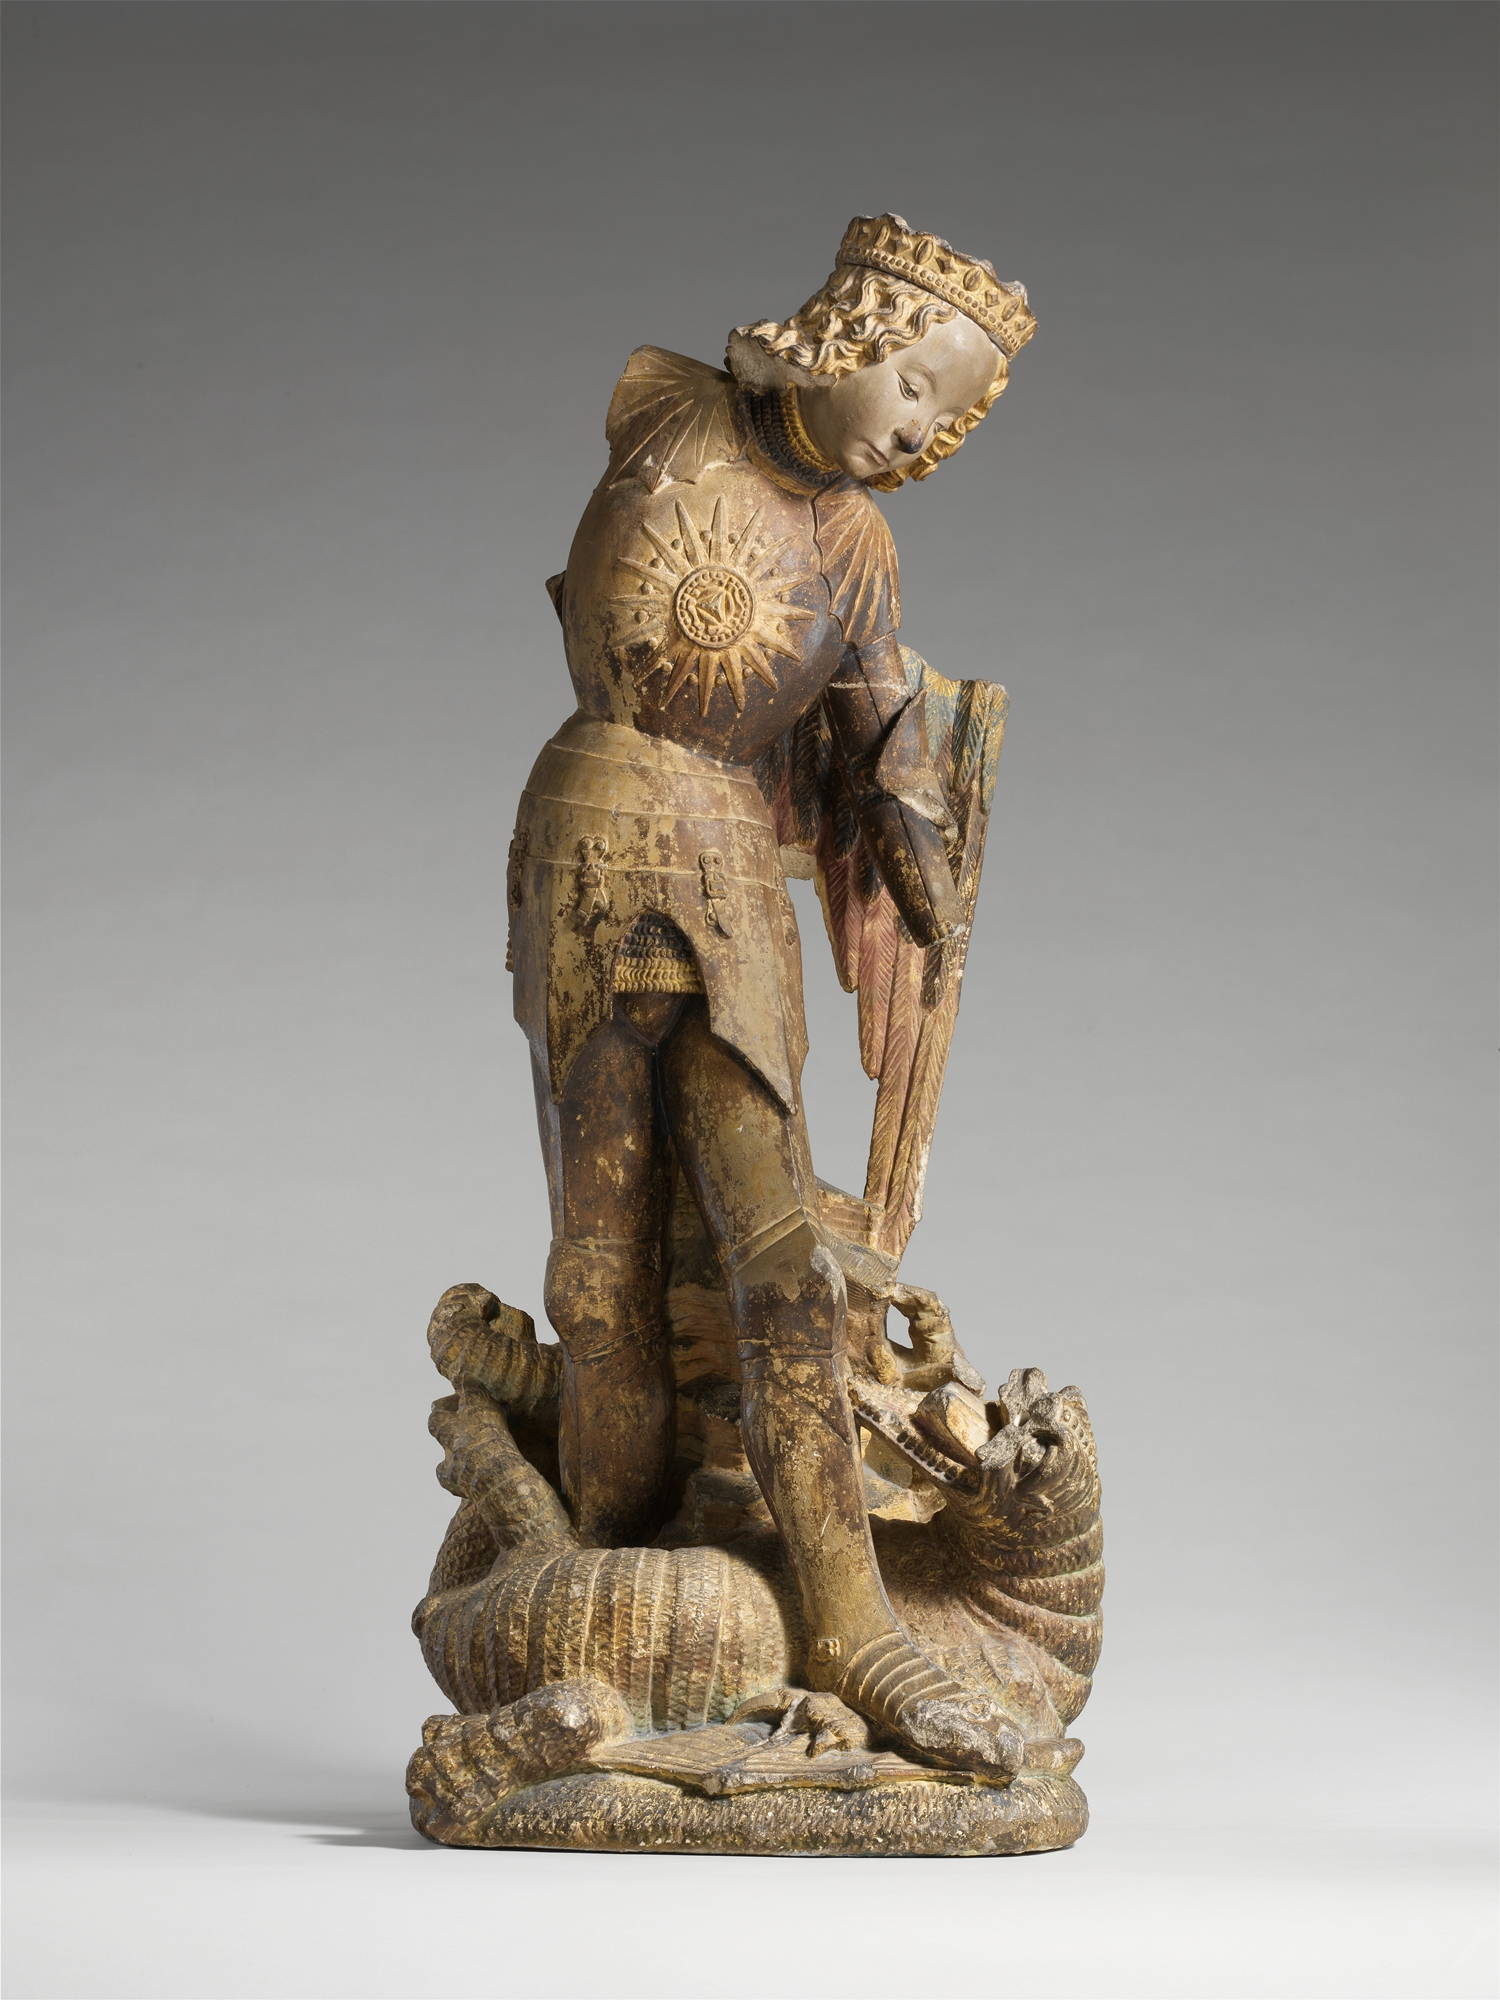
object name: statuette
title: Saint Michael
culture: french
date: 1475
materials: limestone, paint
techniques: gilding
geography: france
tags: dragons